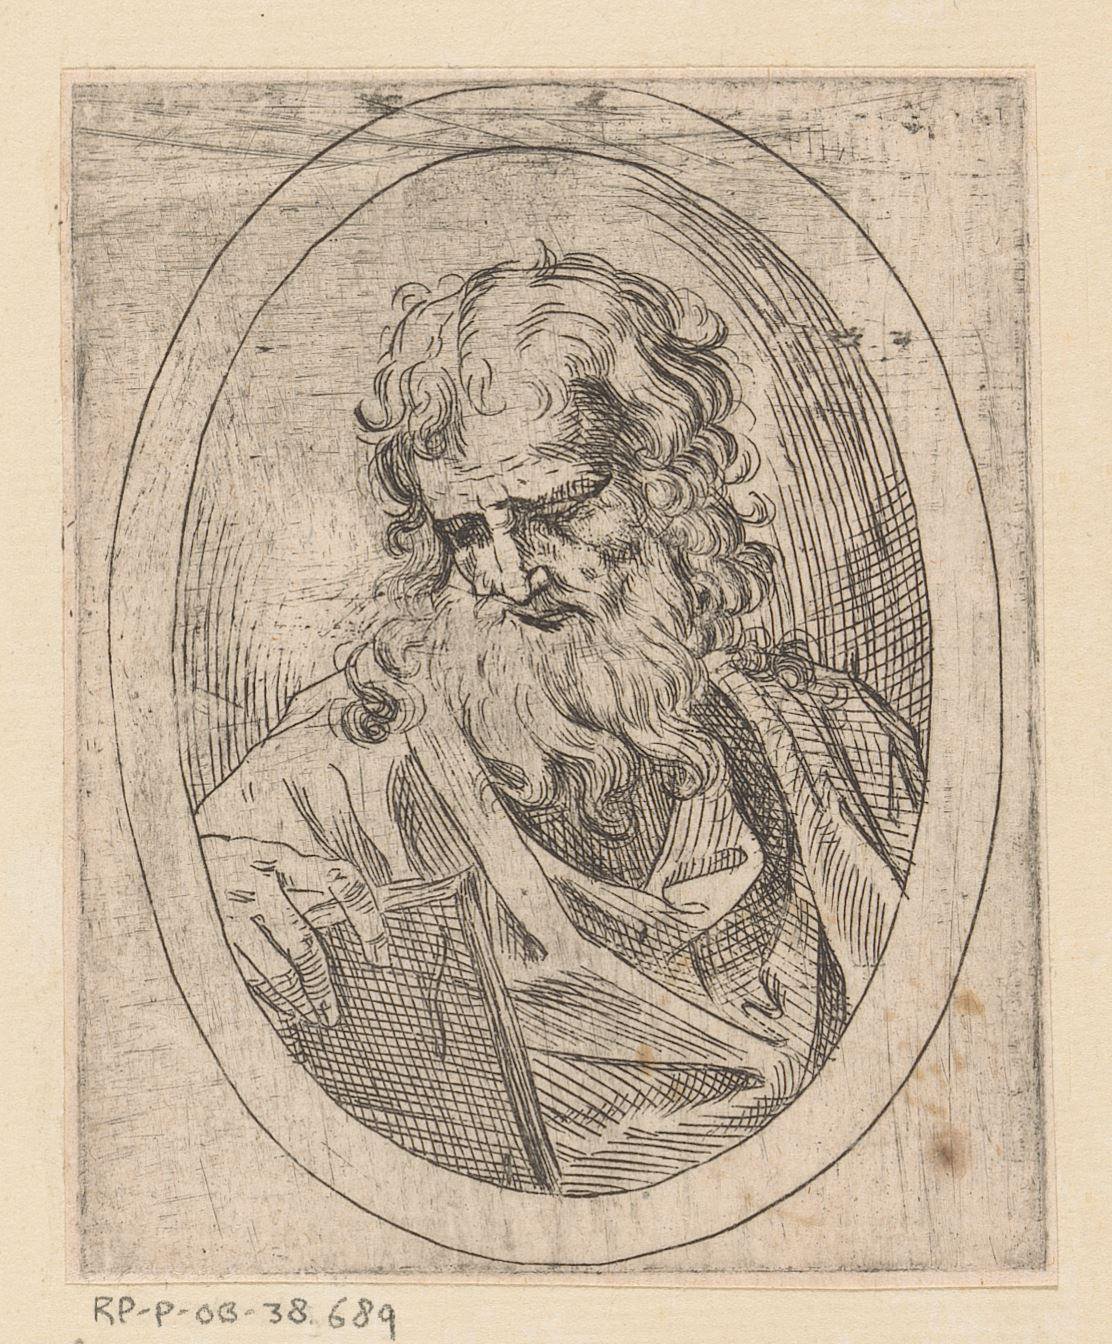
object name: print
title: Apostel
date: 1595-1692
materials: paper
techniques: etching, intaglio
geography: italy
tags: (single) apostle, unspecified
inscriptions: collector's mark: Lugt 240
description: Deze prent maakt deel uit van een serie van vijftien prenten met beeltenissen van Christus, Maria en apostelen, gevat in ovalen.